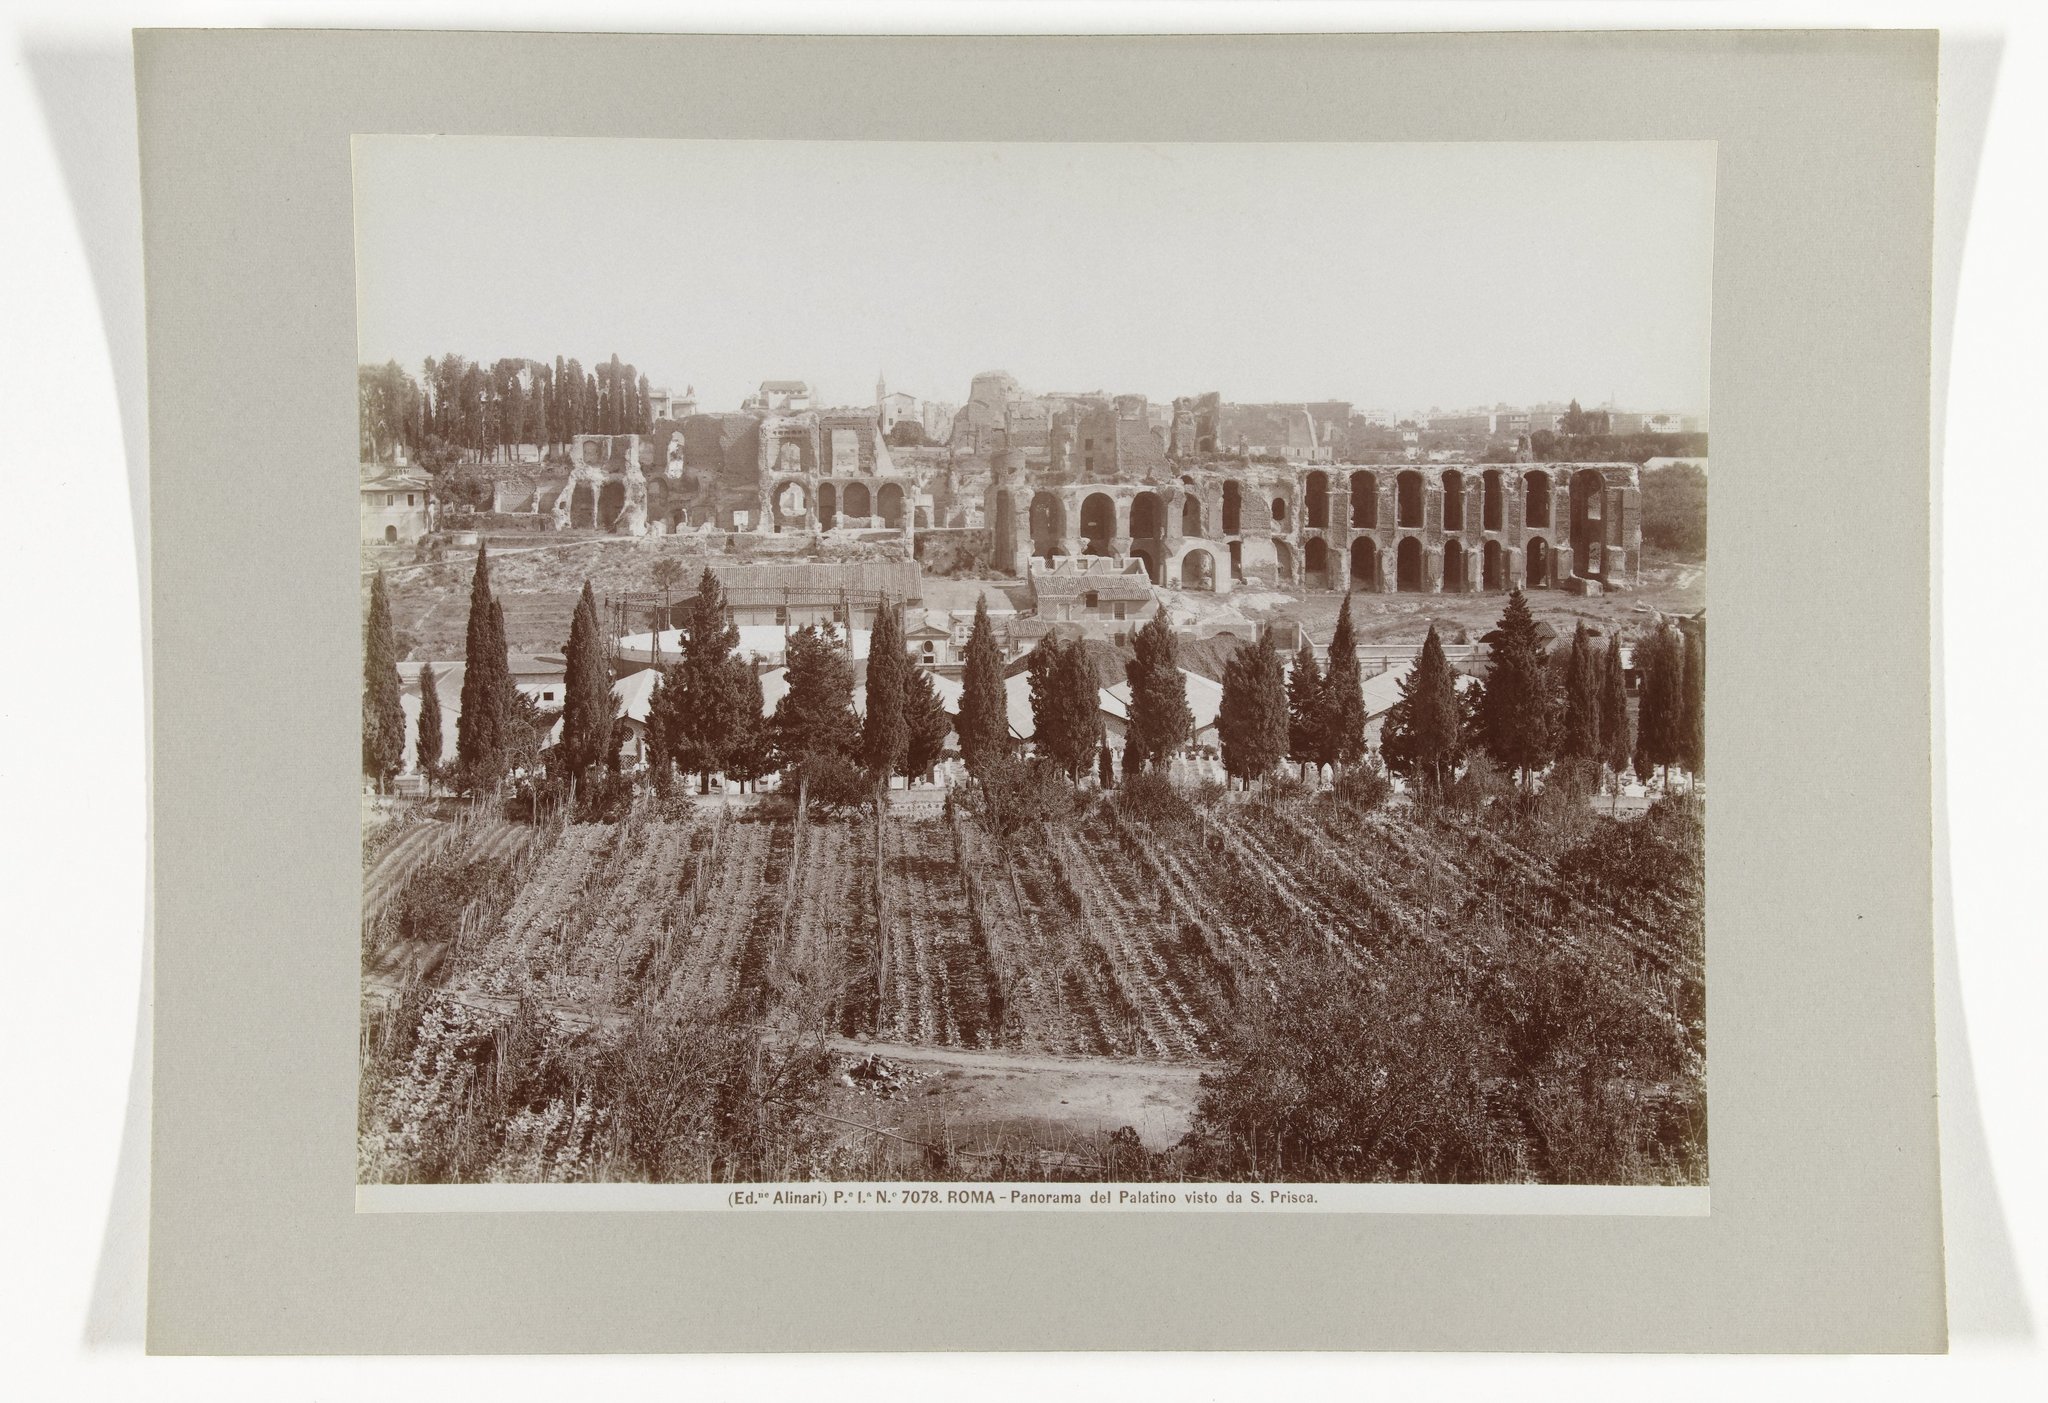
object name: photograph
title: Gezicht op de Monte Palatino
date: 1880-1895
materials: cardboard, paper, photographic support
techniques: albumen print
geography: florence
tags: trees, vineyard, ruin of a building ~ architecture, landscape with ruins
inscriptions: number: ‘19.’